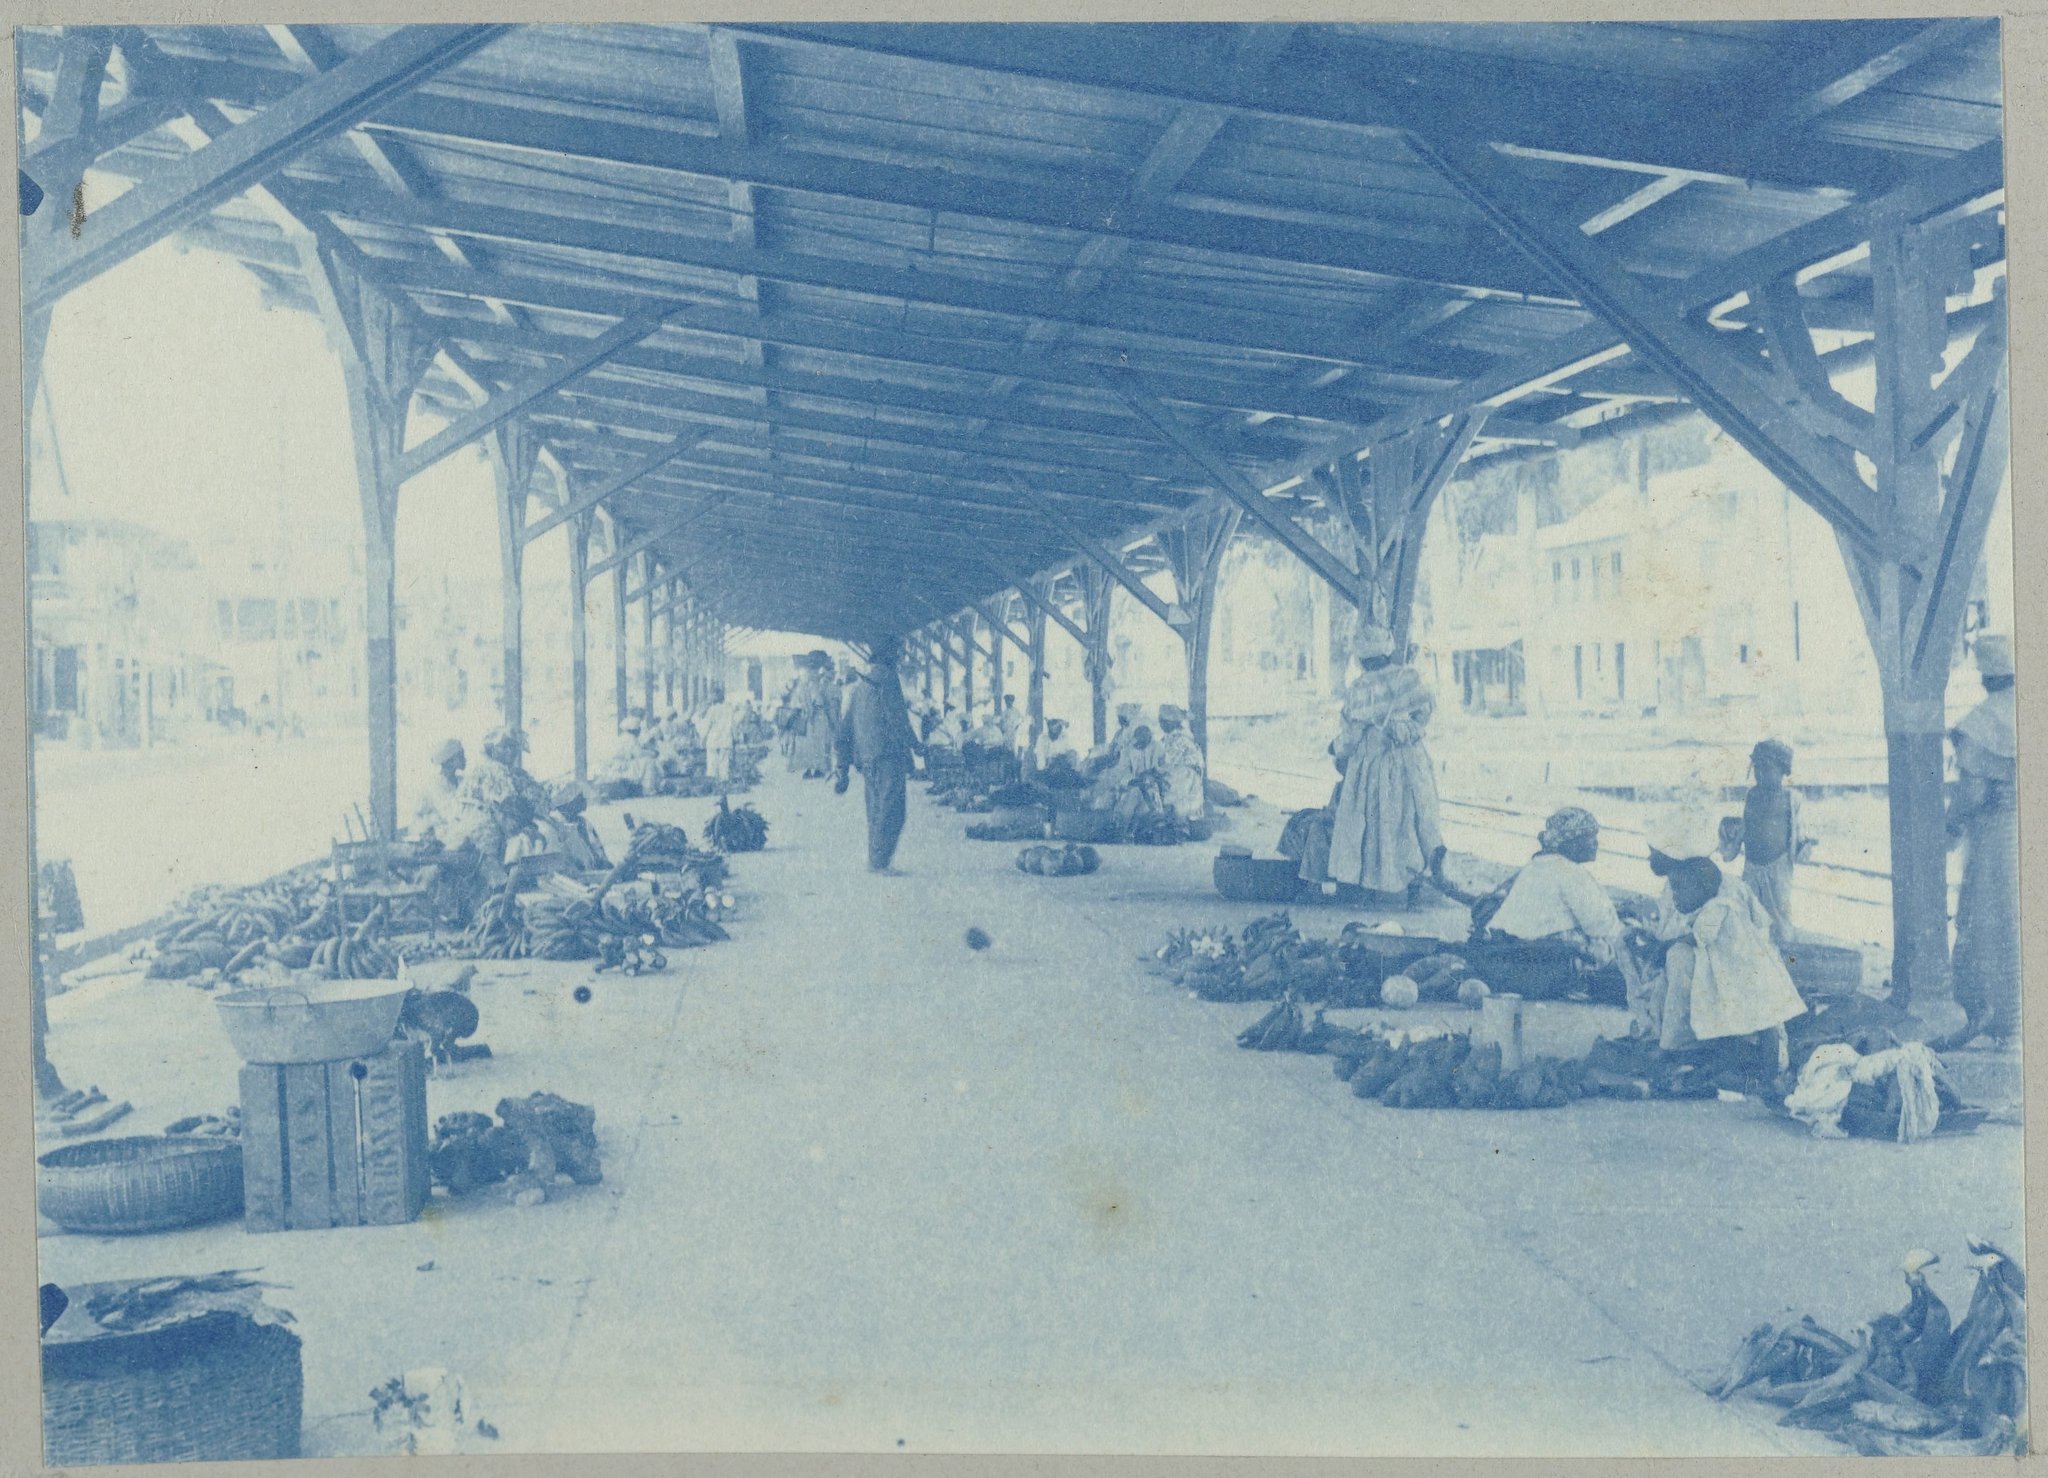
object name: photograph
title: Overdekte markt aan Heiligenweg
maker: hendrik doijer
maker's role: engineer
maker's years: 1863-1925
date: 1903-1910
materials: photographic support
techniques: cyanotype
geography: suriname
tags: suriname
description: Gezicht in de overdekte markt aan de Heiligenweg te Paramaribo. Verkopers zitten met hun waar op de grond. Onderdeel van het fotoalbum Souvenir de Voyage (deel 2), over het leven van de familie Doijer in en rond de plantage Ma Retraite in Suriname in de jaren 1903-1910.